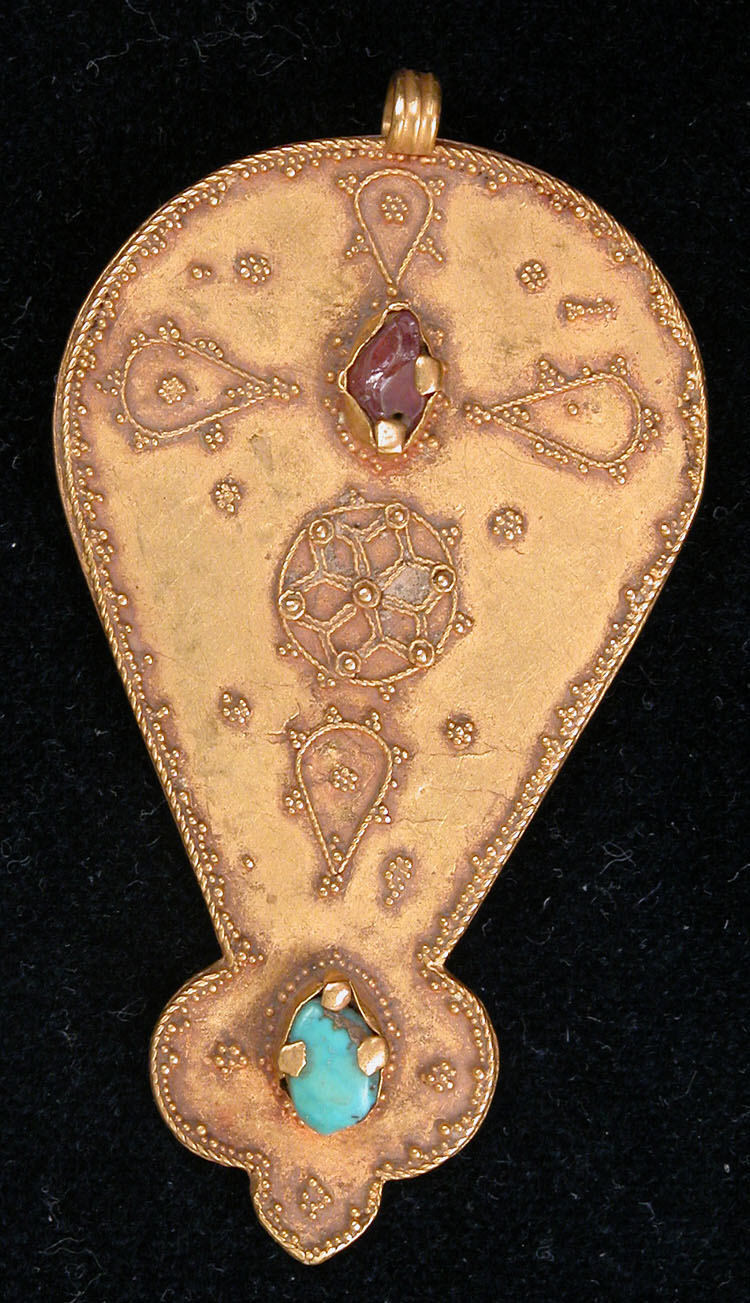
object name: pendant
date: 1001-1200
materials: gold, pearl, gemstone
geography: iran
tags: pendants